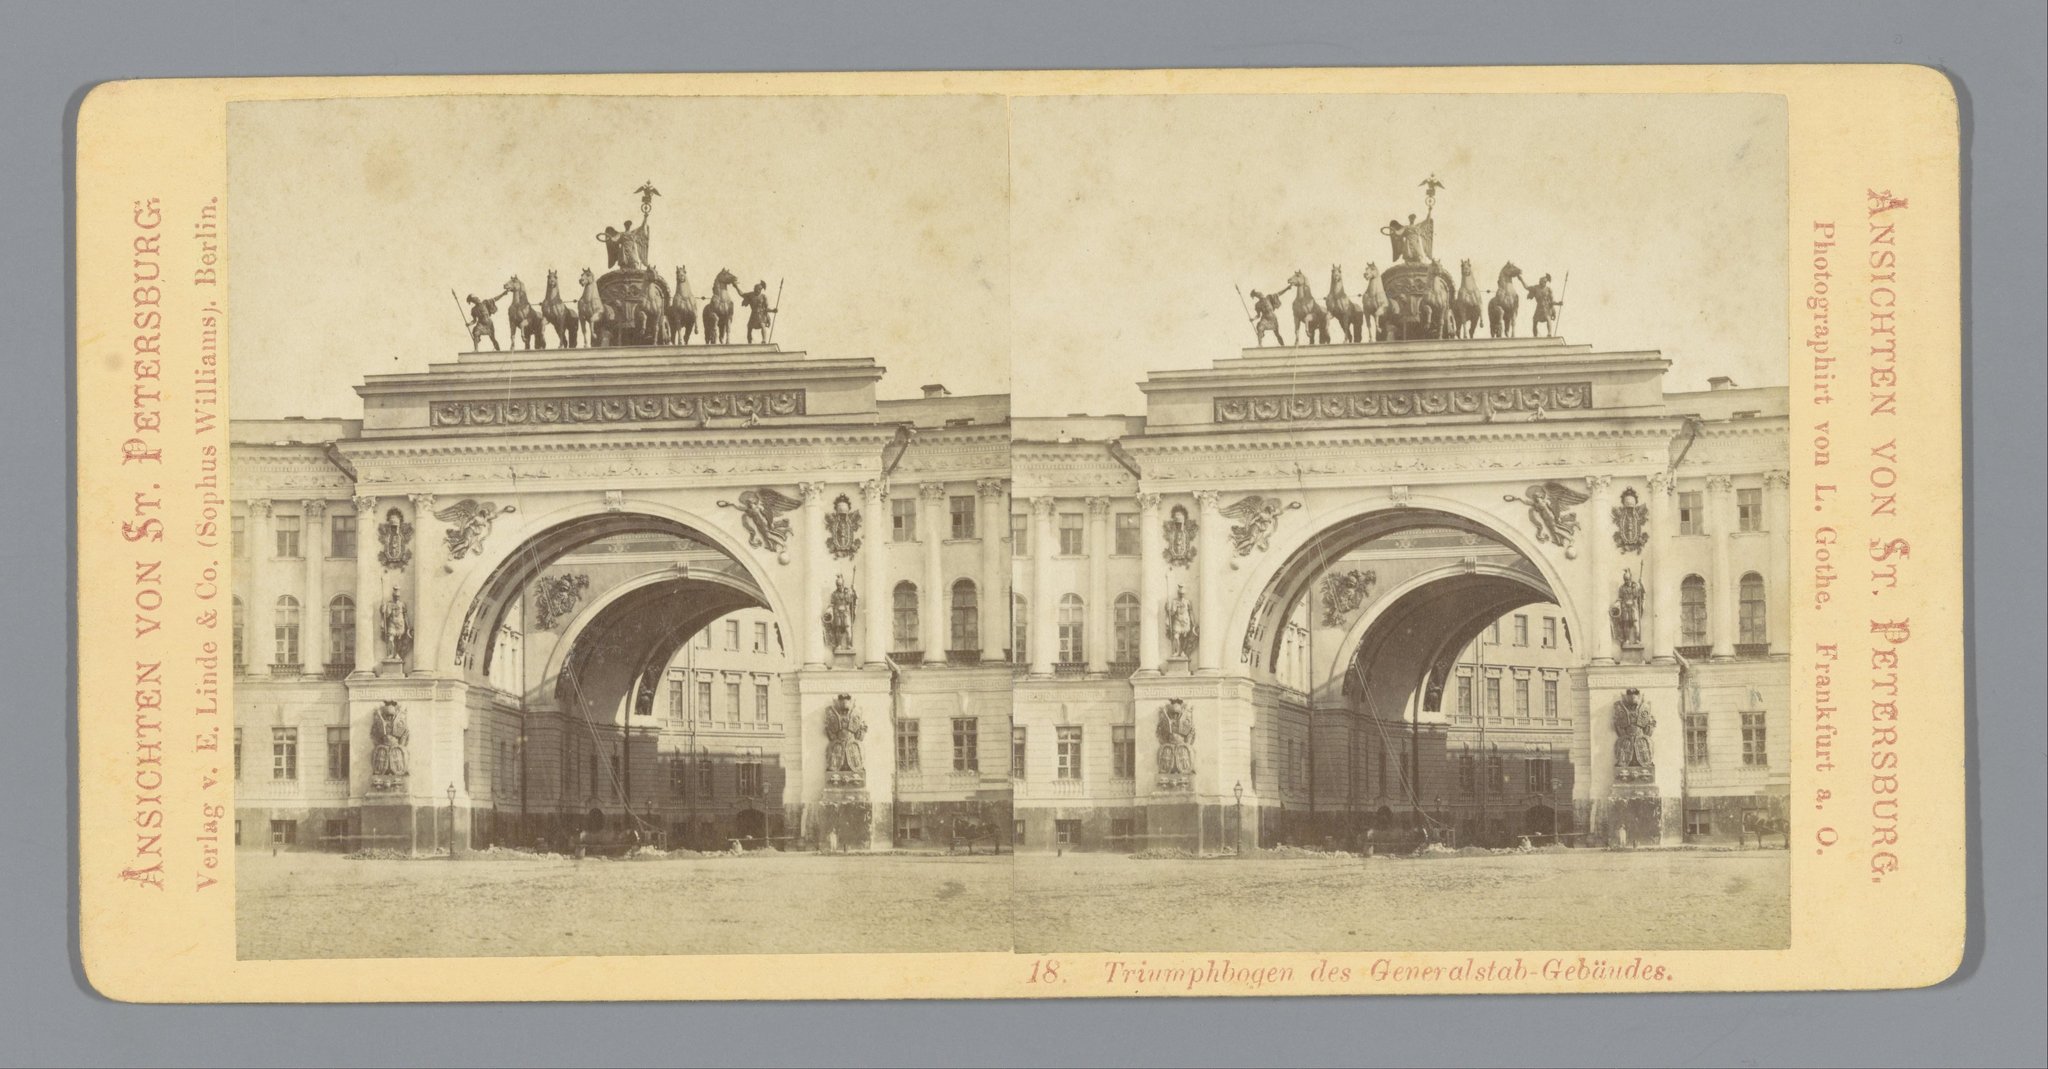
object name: stereograph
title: Triumphbogen des Generalstab-Gebäudes.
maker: louis gothe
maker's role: fotograaf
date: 1850-1880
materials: cardboard, photographic support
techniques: albumen print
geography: sint-petersburg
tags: triumphal arch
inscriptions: number: ‘18.’, inscription: ‘Ansichten von St. Petersburg.’